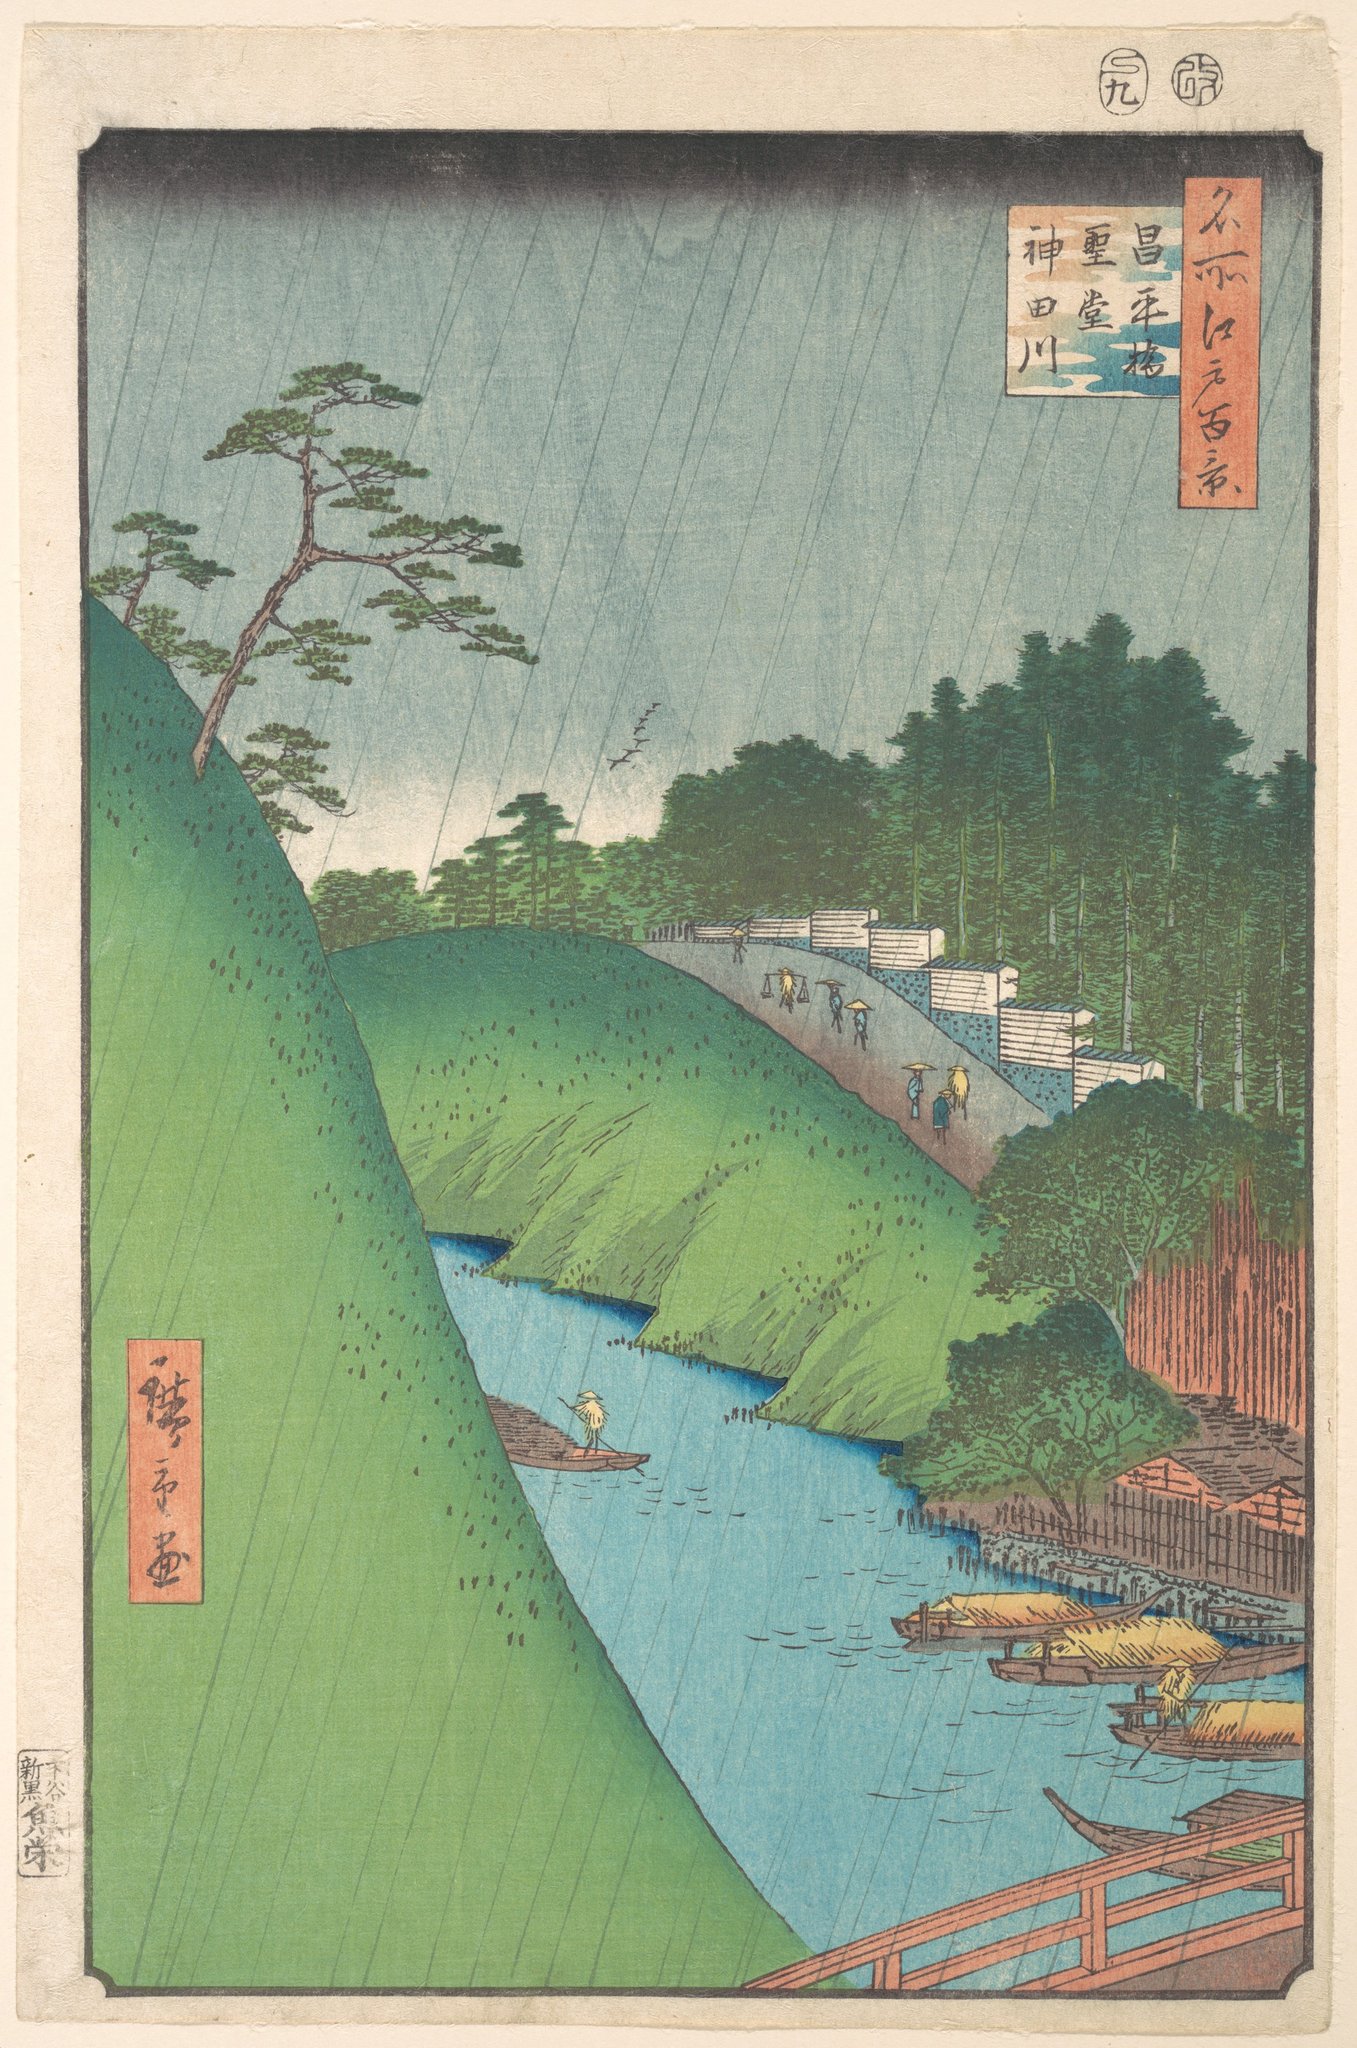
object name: print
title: Shohei Bridge, Seido Temple and Kanda River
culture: japanese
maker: utagawa hiroshige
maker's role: artist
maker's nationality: japanese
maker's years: 1797-1858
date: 1857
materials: ink, paper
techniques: woodblock print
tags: human figures,bridges,rivers,rain,boats